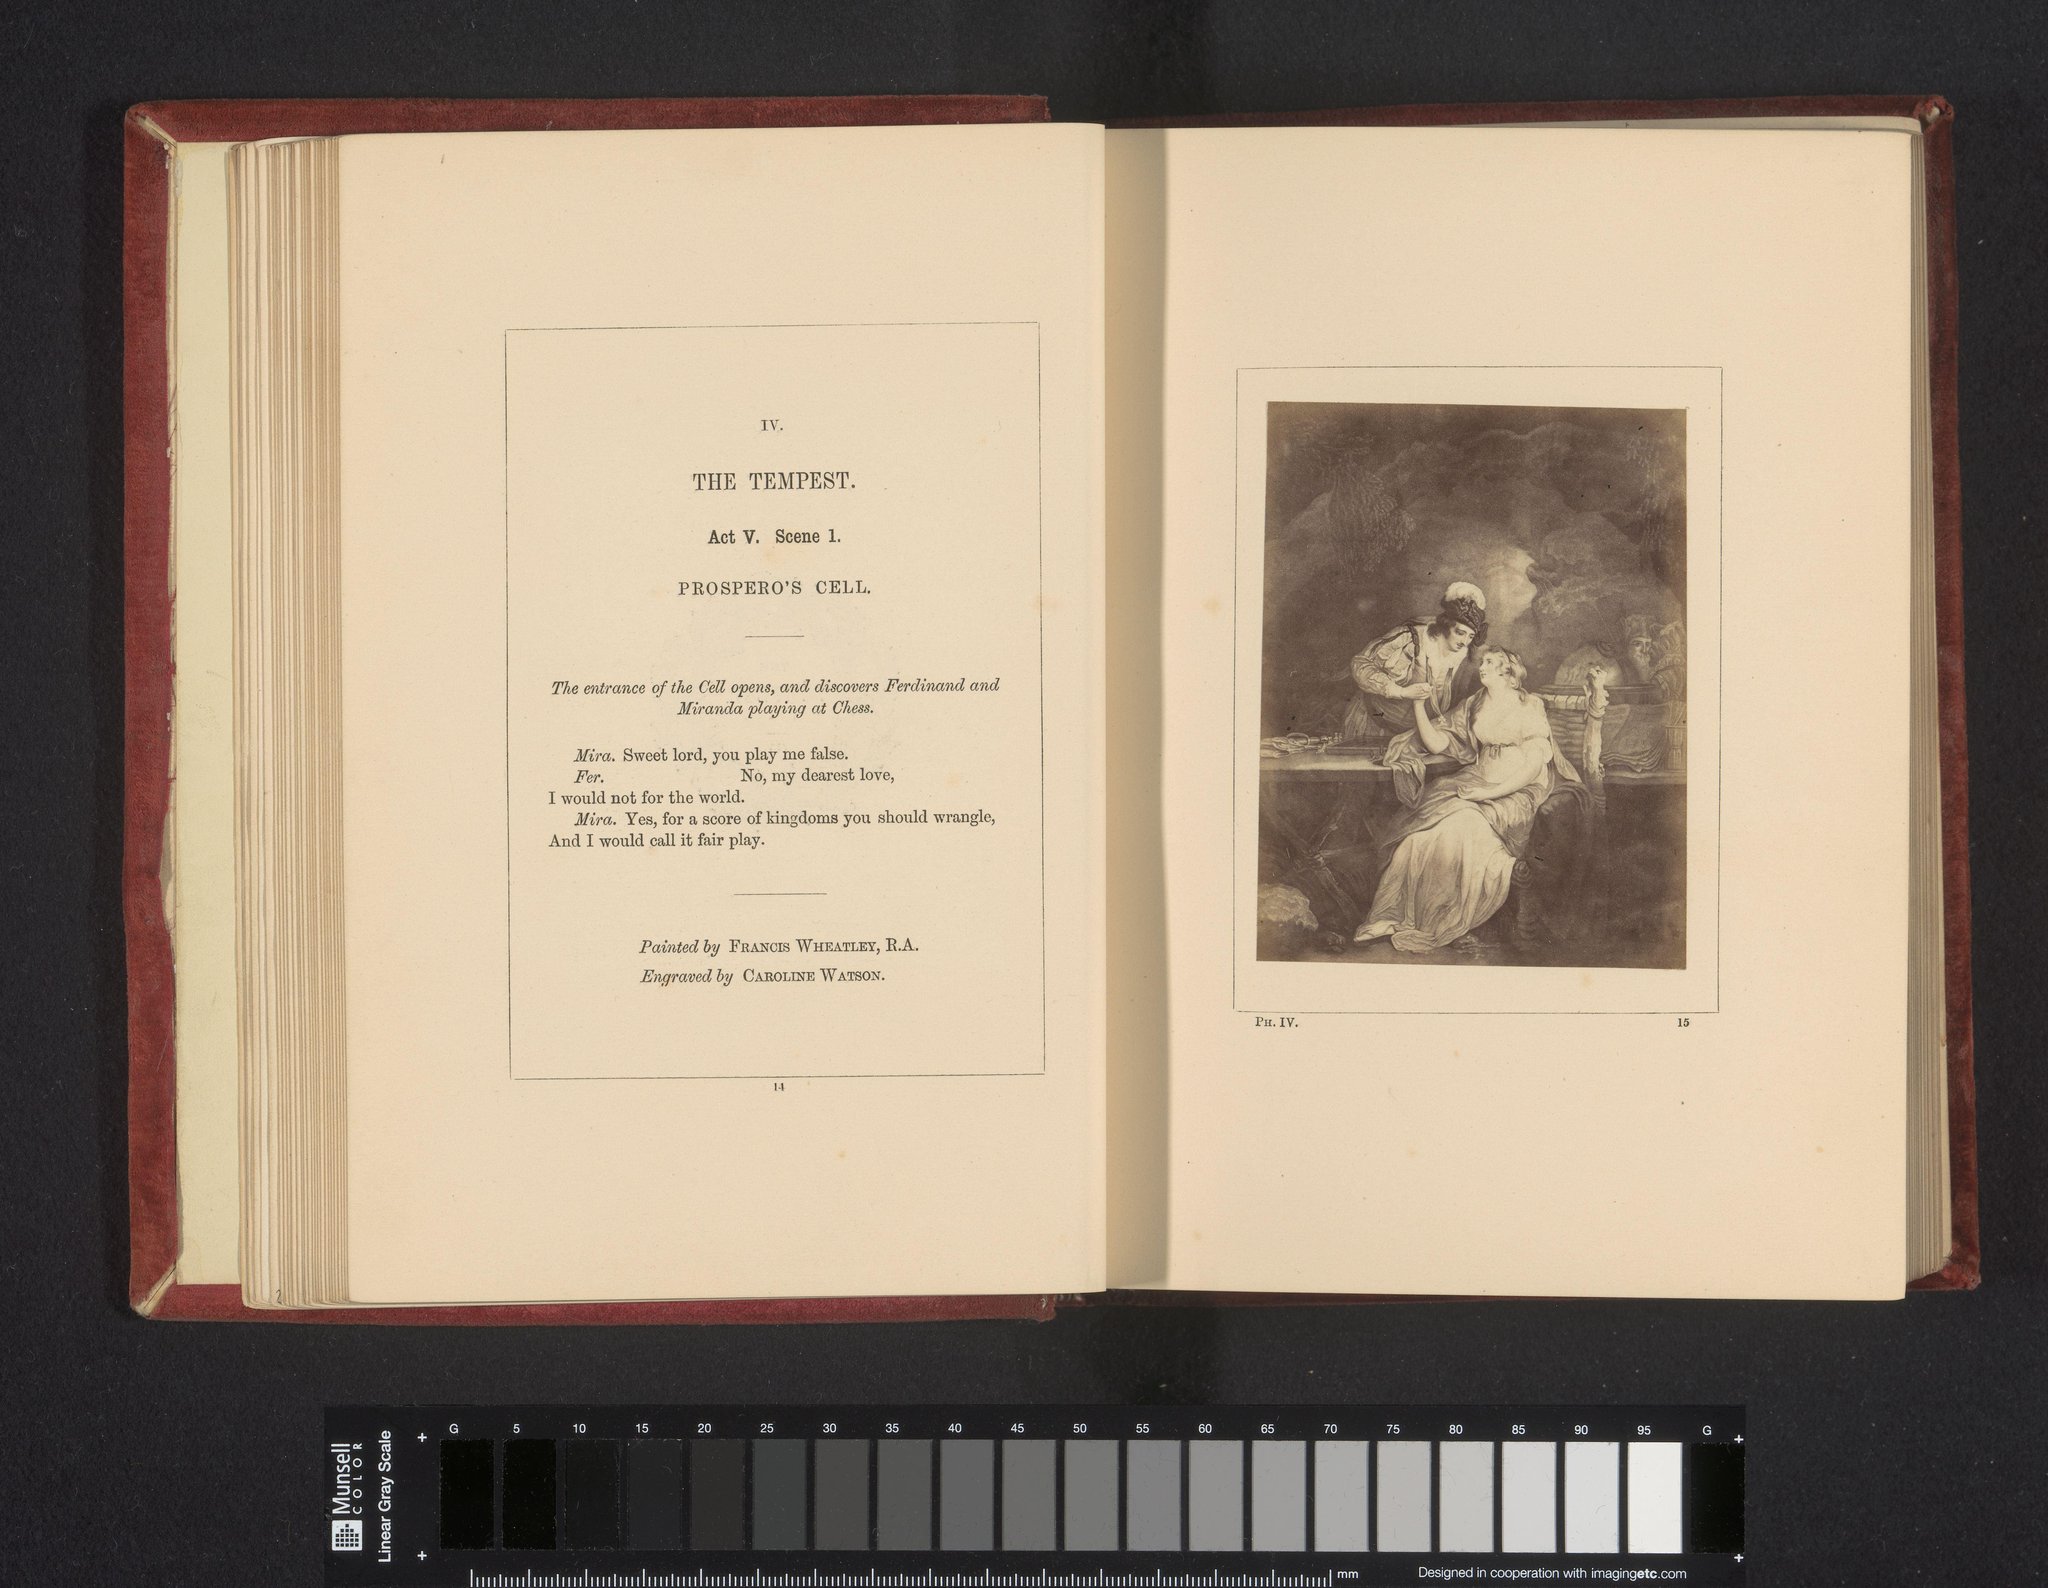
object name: page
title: Fotoreproductie van een prent naar een schilderij door Francis Wheatley, voorstellend een scene uit De Storm door William Shakespeare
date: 1854-1864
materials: photographic support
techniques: albumen print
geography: london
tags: (scenes from) specific works of literature: shakespeare, tempest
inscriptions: number: ‘Ph. IV. 15’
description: Te zien is akte V, scene 1: Ferdinand en Miranda spelen schaak.